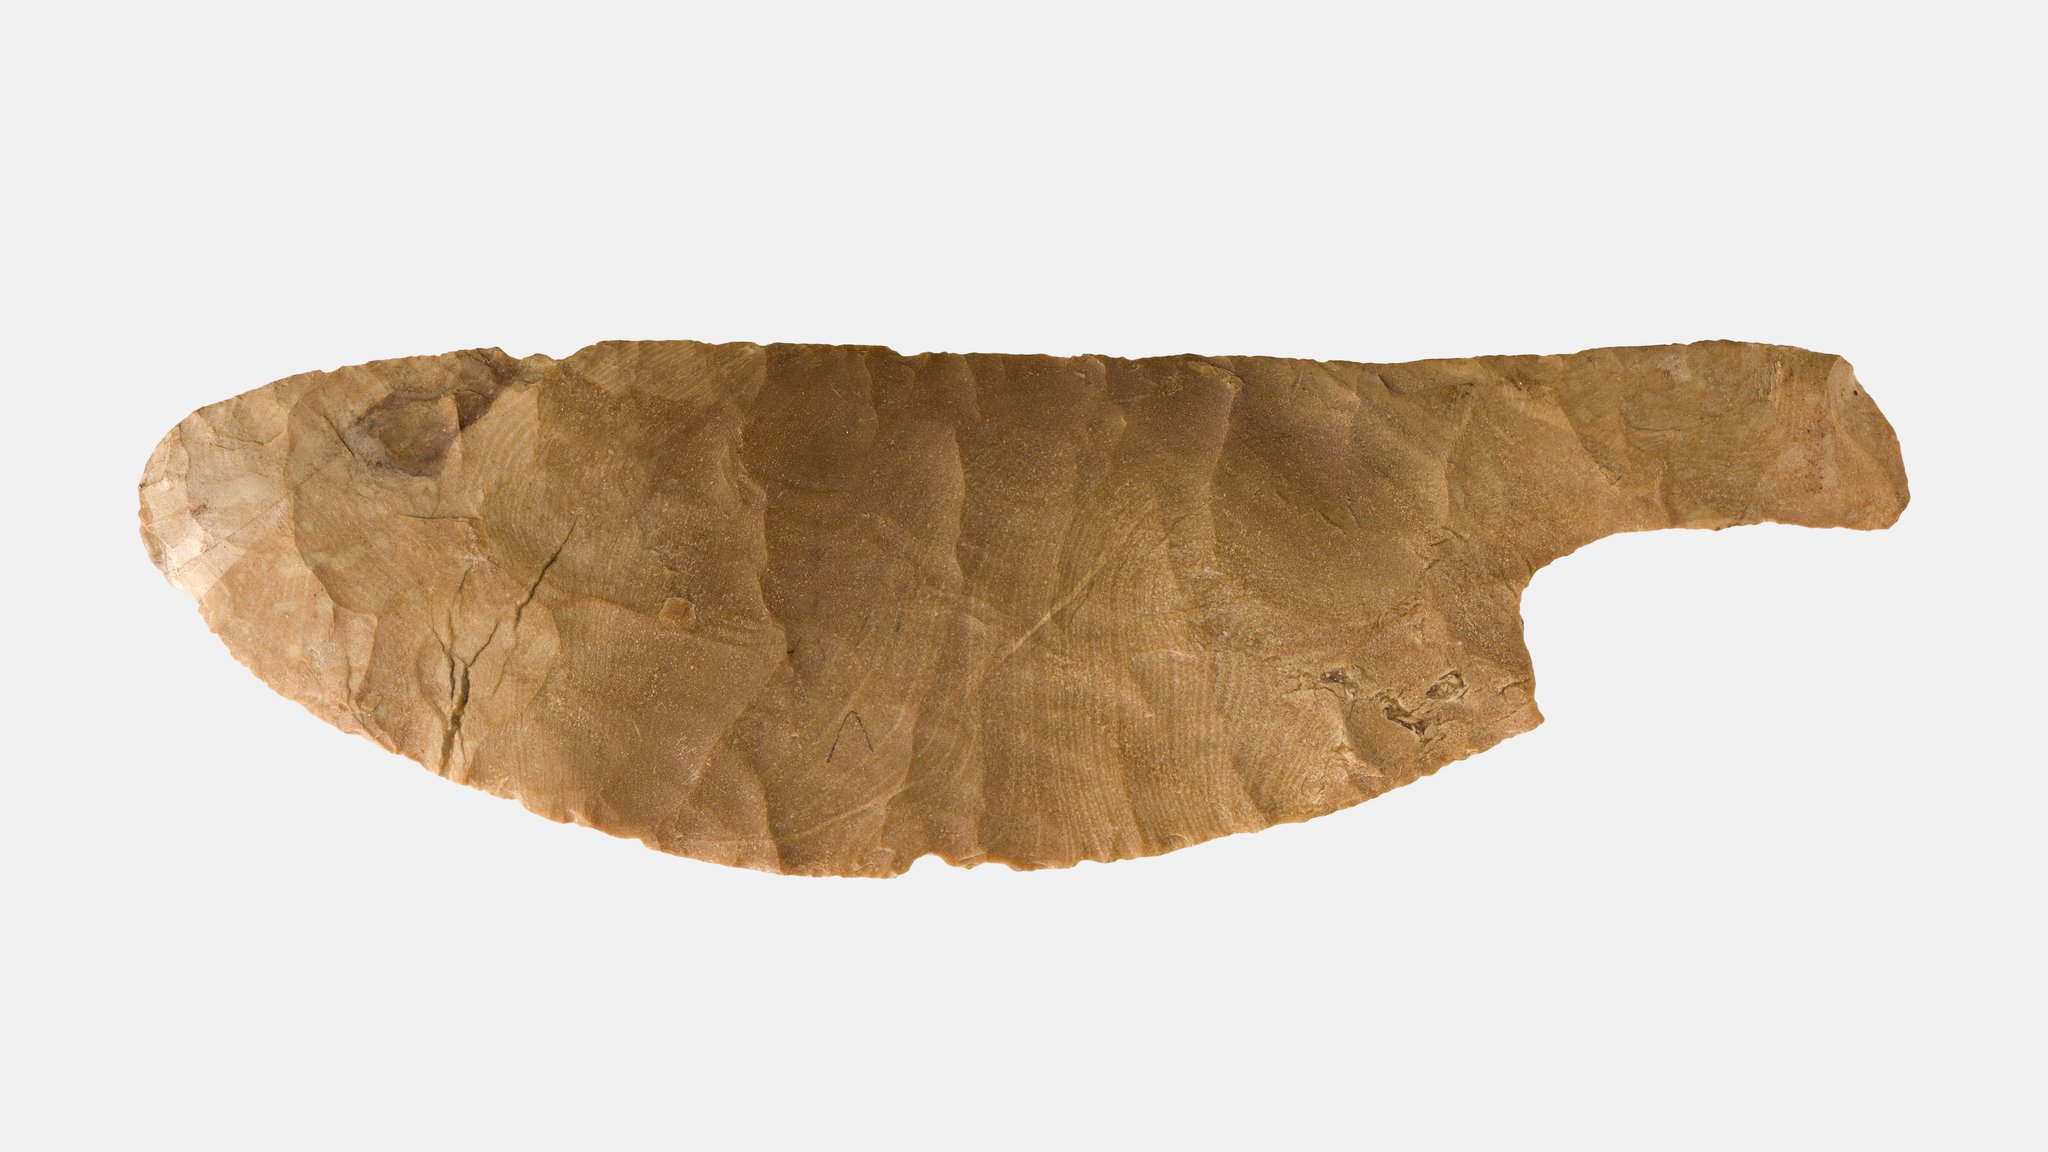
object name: knife, bifacial knife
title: Bifacial knife with handle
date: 2949 BCE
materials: stone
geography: egypt